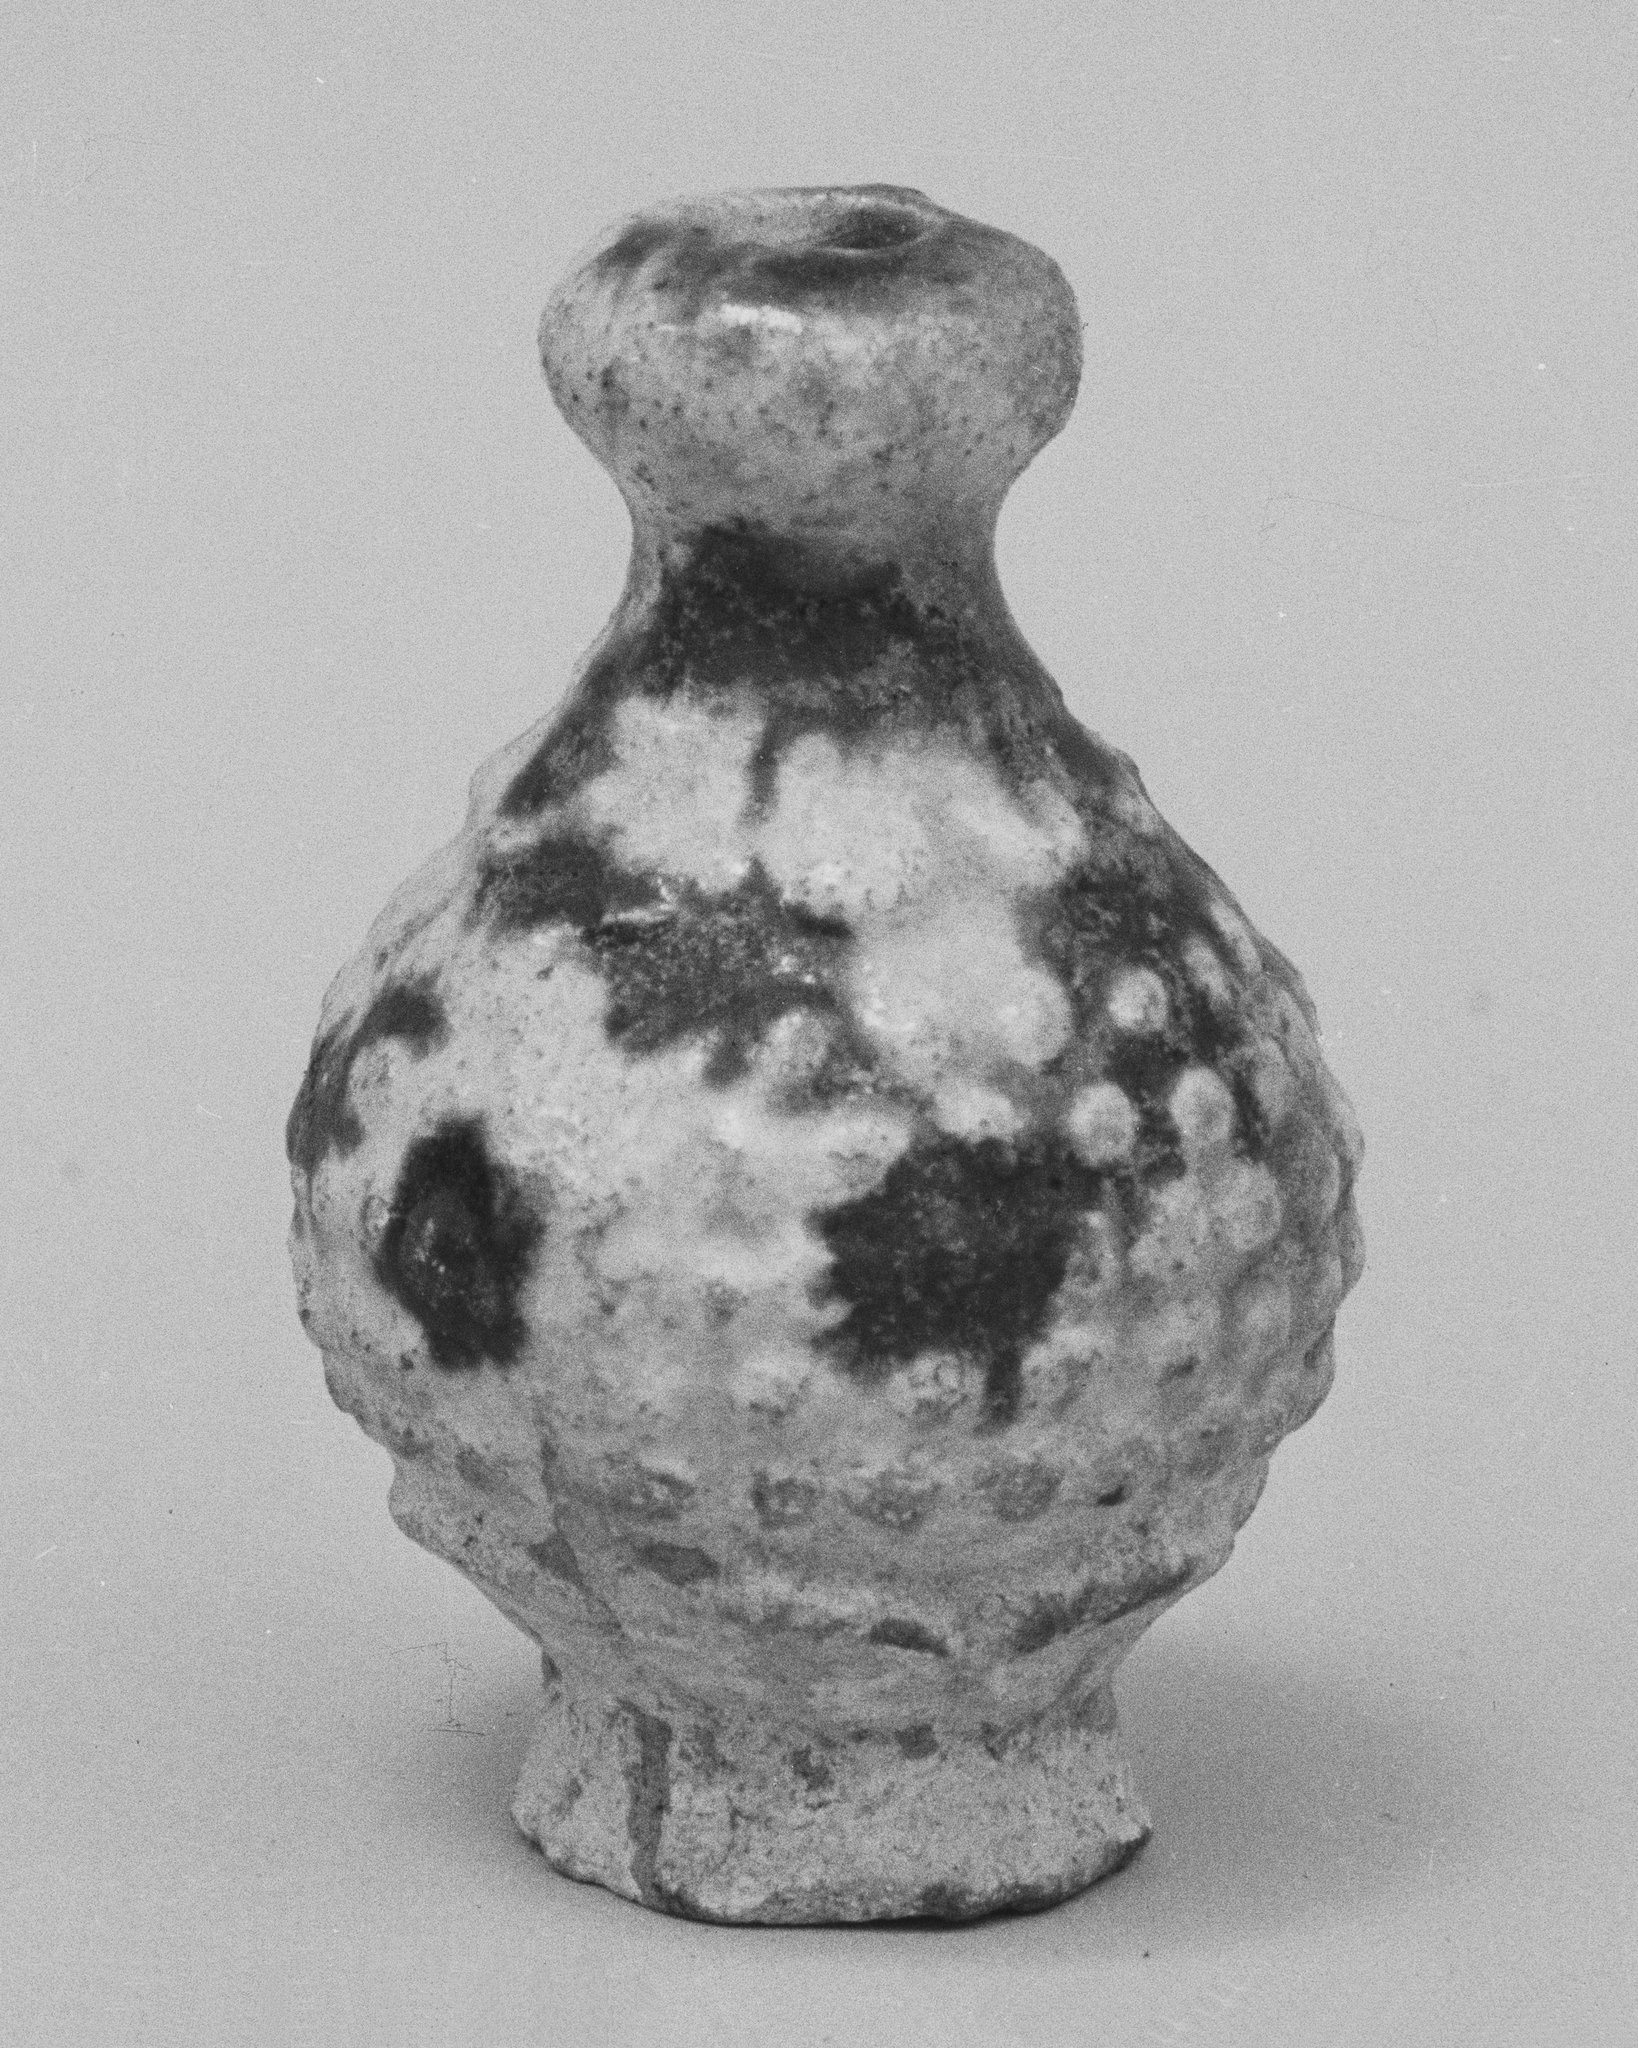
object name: bottlw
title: Miniature bottle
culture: chinese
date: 601-800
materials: earthenware, glaze